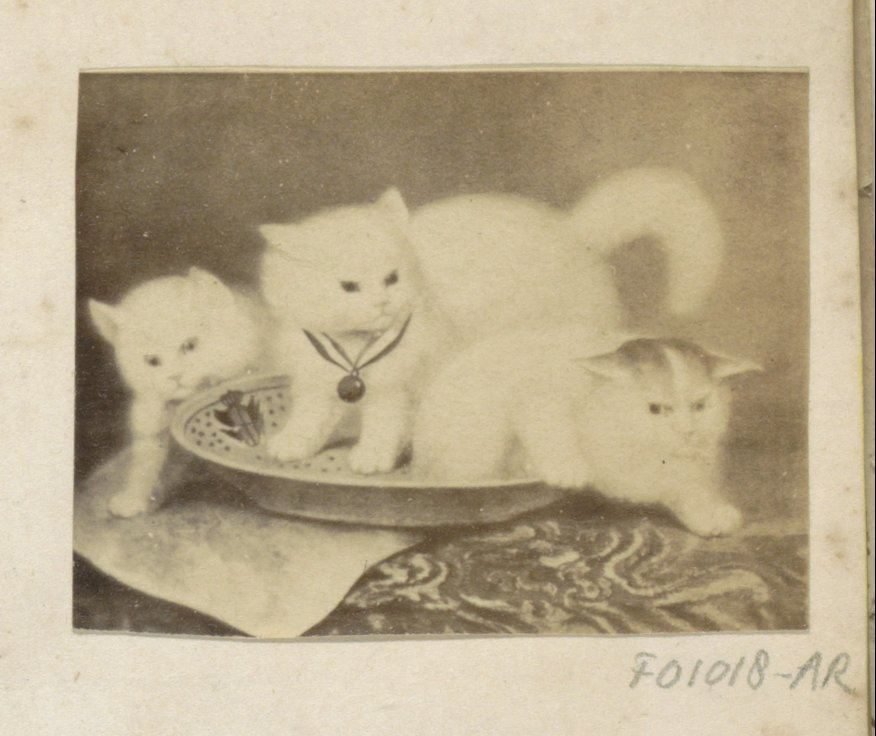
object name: reproduction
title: Fotoreproductie van (vermoedelijk) een schilderij met drie katten in een schaal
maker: Anonymous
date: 1860-1870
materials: paper, photographic support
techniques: albumen print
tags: cat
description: Onderdeel van Engels familiealbum met foto's van personen, reizen, cricket en kunstwerken.